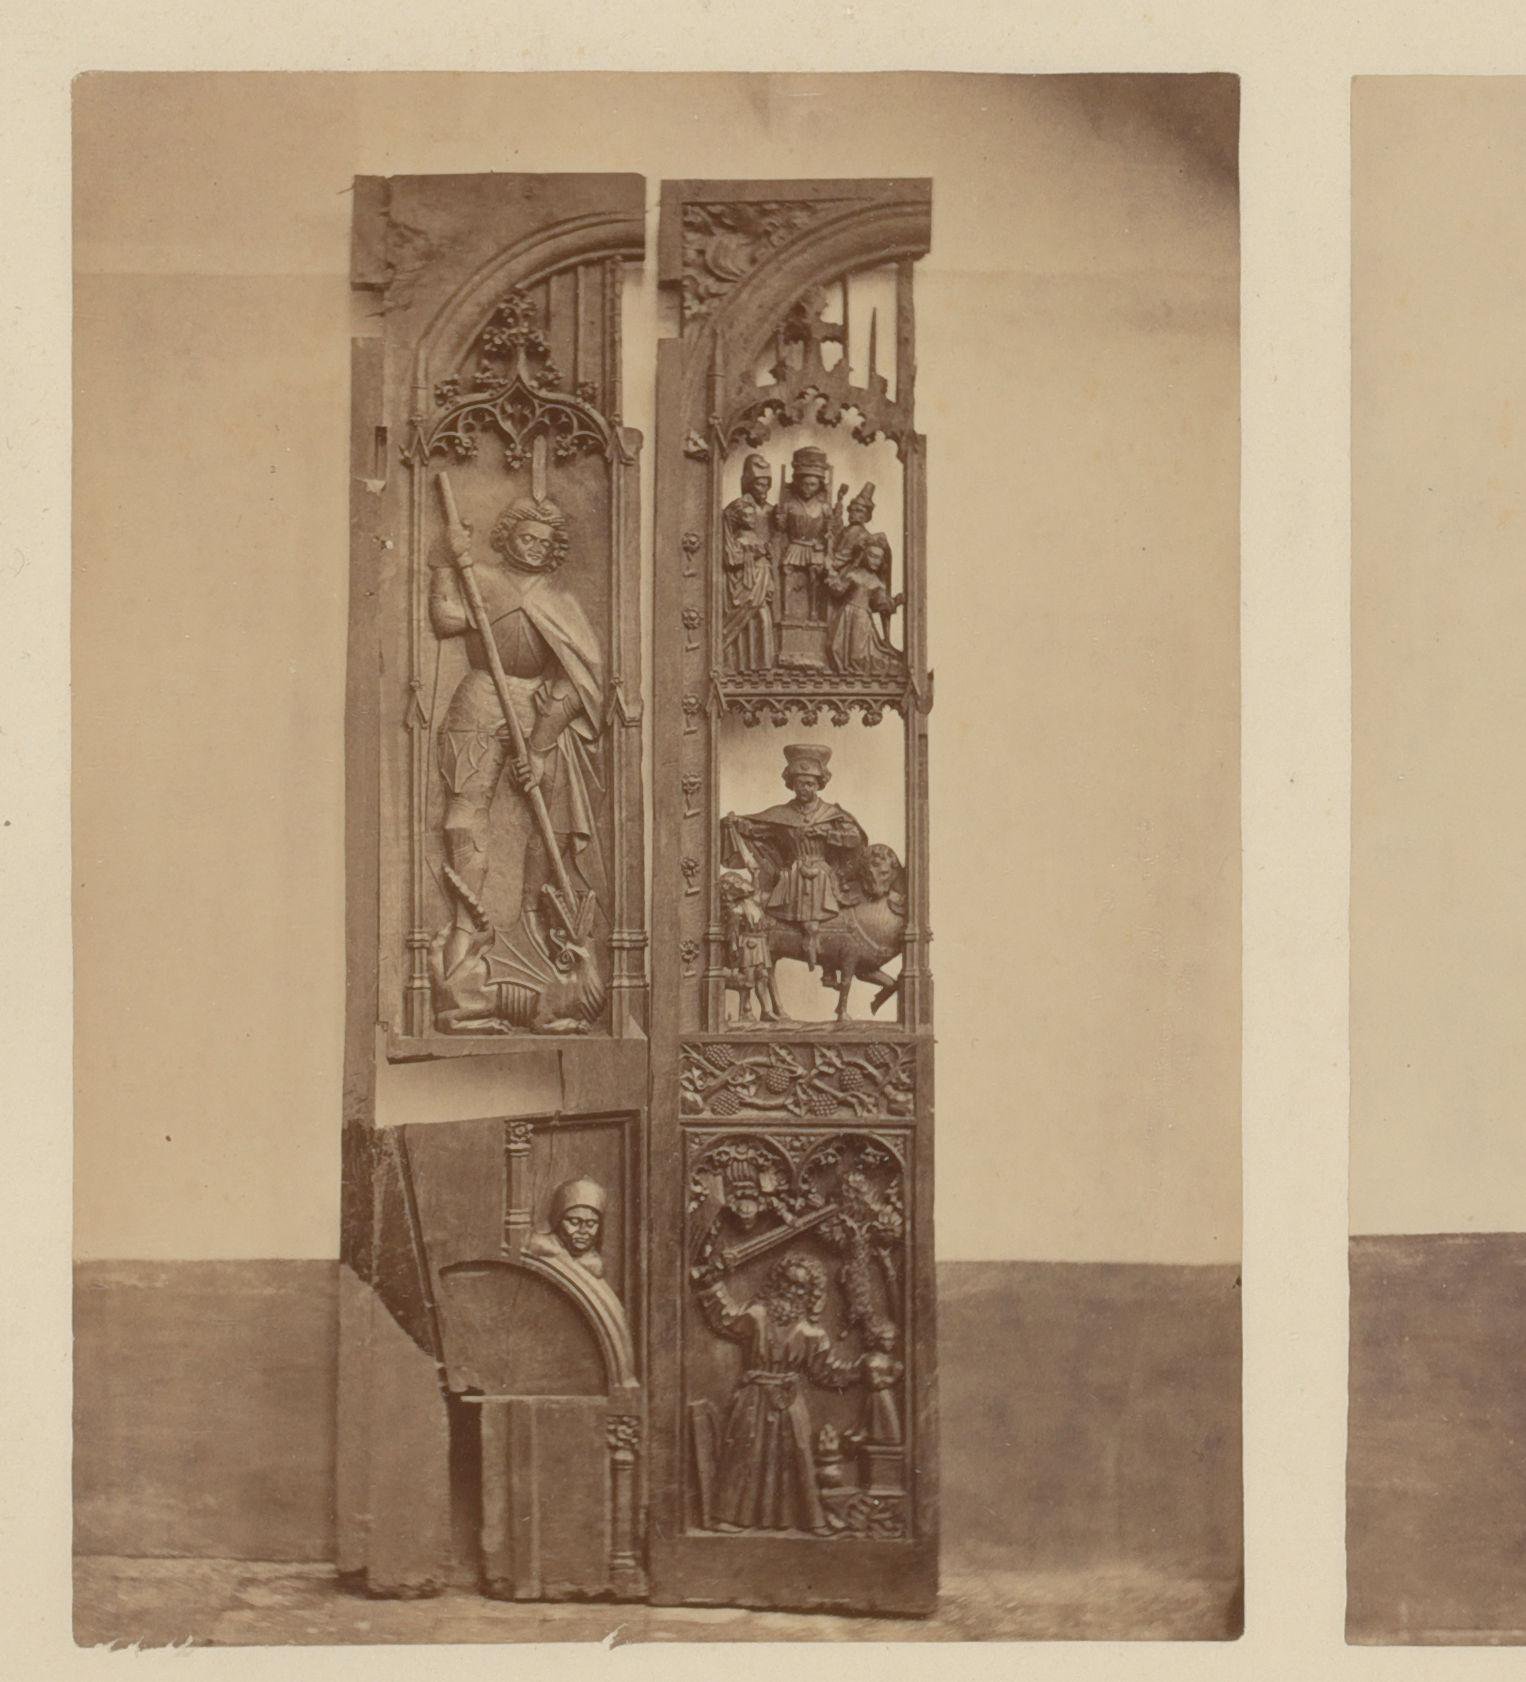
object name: photograph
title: Paneel met houtsnijwerk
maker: g.m. märckelbach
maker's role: publisher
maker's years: 1853-1904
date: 1879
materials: photographic support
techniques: albumen print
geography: bolsward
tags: carving ~ applied arts, piece of sculpture, reproduction of a piece of sculpture, wood carver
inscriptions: collector's mark, collector's mark: Lugt 1641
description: In een advertentie wordt de fotoserie aangeboden: HH. Liefhebbers van Antiquiteiten. GOTHIEKE BANKEN uit de XVe Eeuw. St. MARTINIKERK.--BOLSWARD. 8 Photographieën à f 4.50. ANTIEKE PREEKSTOEL, uit het midden der XVIIe EEUW. 4 Photographieën à f 2.25. Uitgave van: GEBRs. CORDES, Photografen [and] G.M. MÄRCKELBACH, Boek- en Kunsthandel, BOLSWARD. (Het nieuws van den dag: kleine courant, 12-07-1879.)